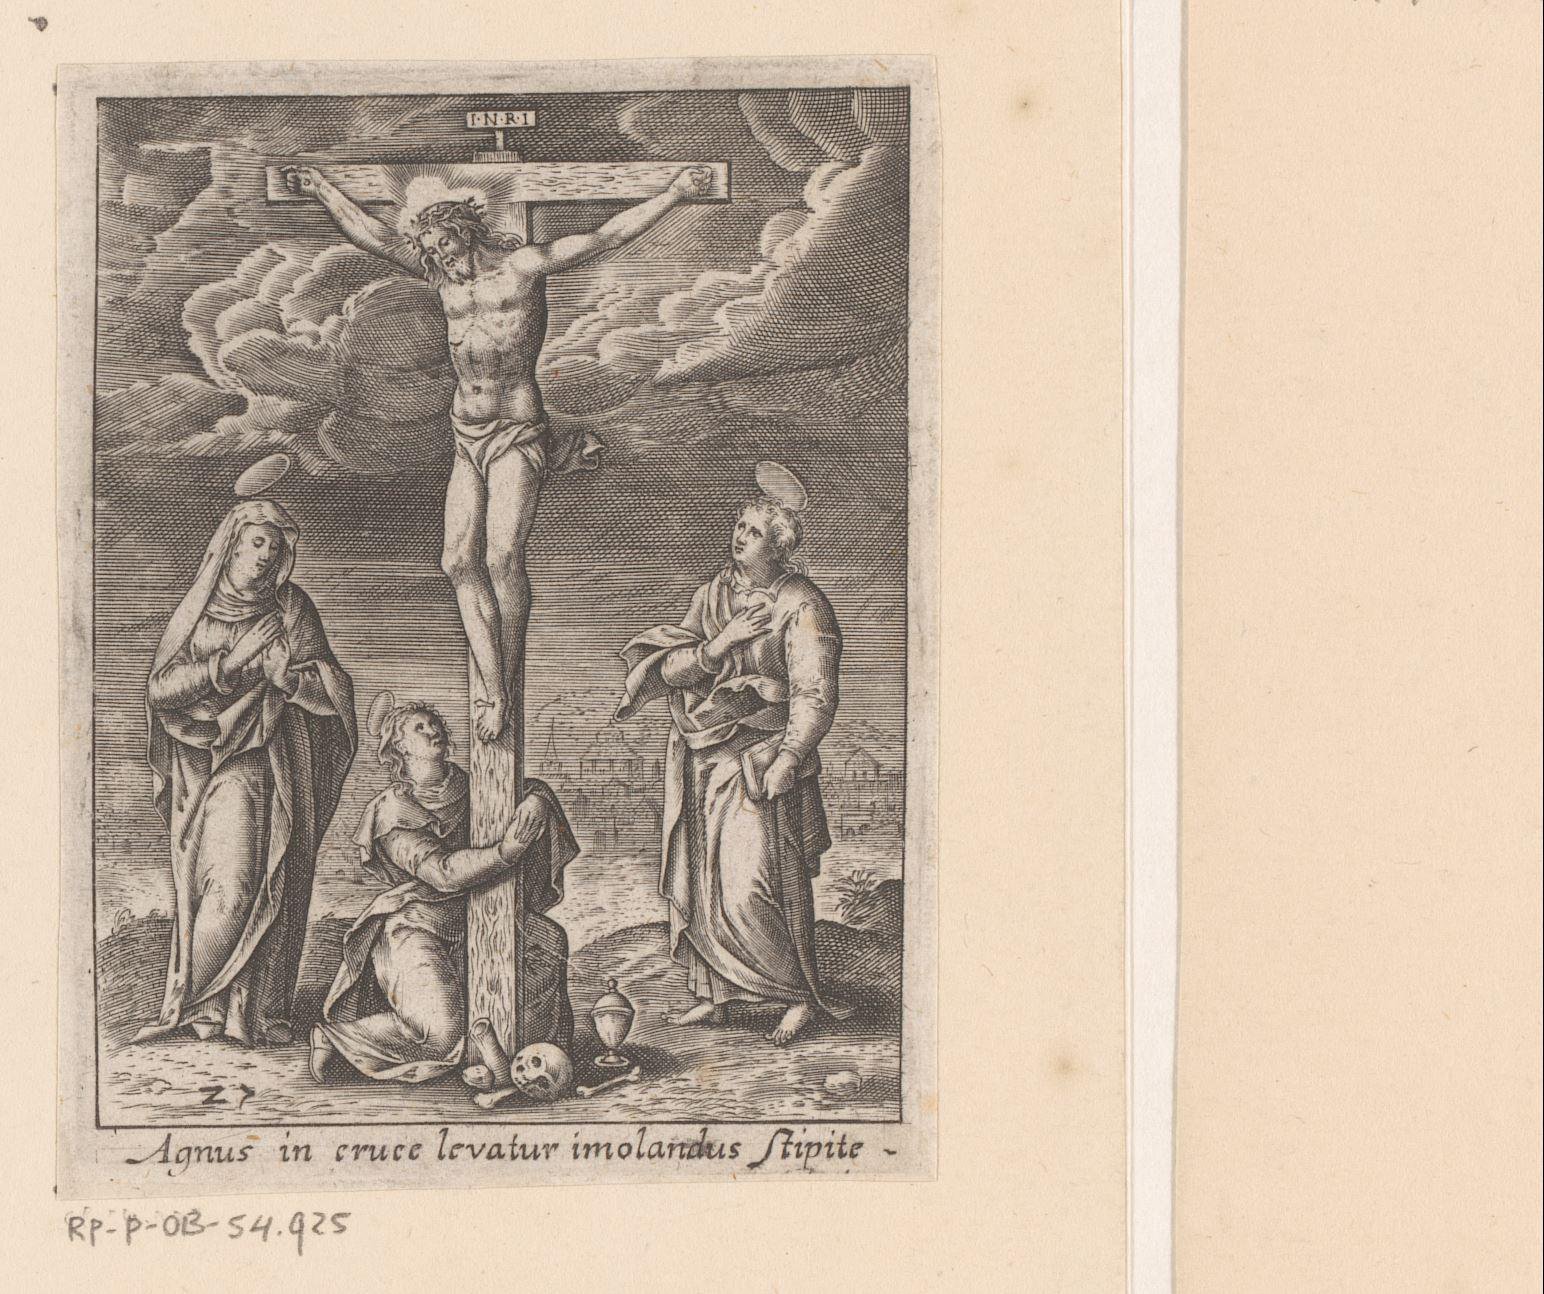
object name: print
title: Christus aan het kruis met Maria, Johannes en Maria Magdalena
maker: heinrich ulrich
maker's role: draughtsman, painter, print maker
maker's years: 1572-1671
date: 1582-1671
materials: paper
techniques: engraving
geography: germany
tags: crucified christ with mary, john, and mary magdalene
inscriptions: number: ‘38. - 64.’, collector's mark: Lugt 240